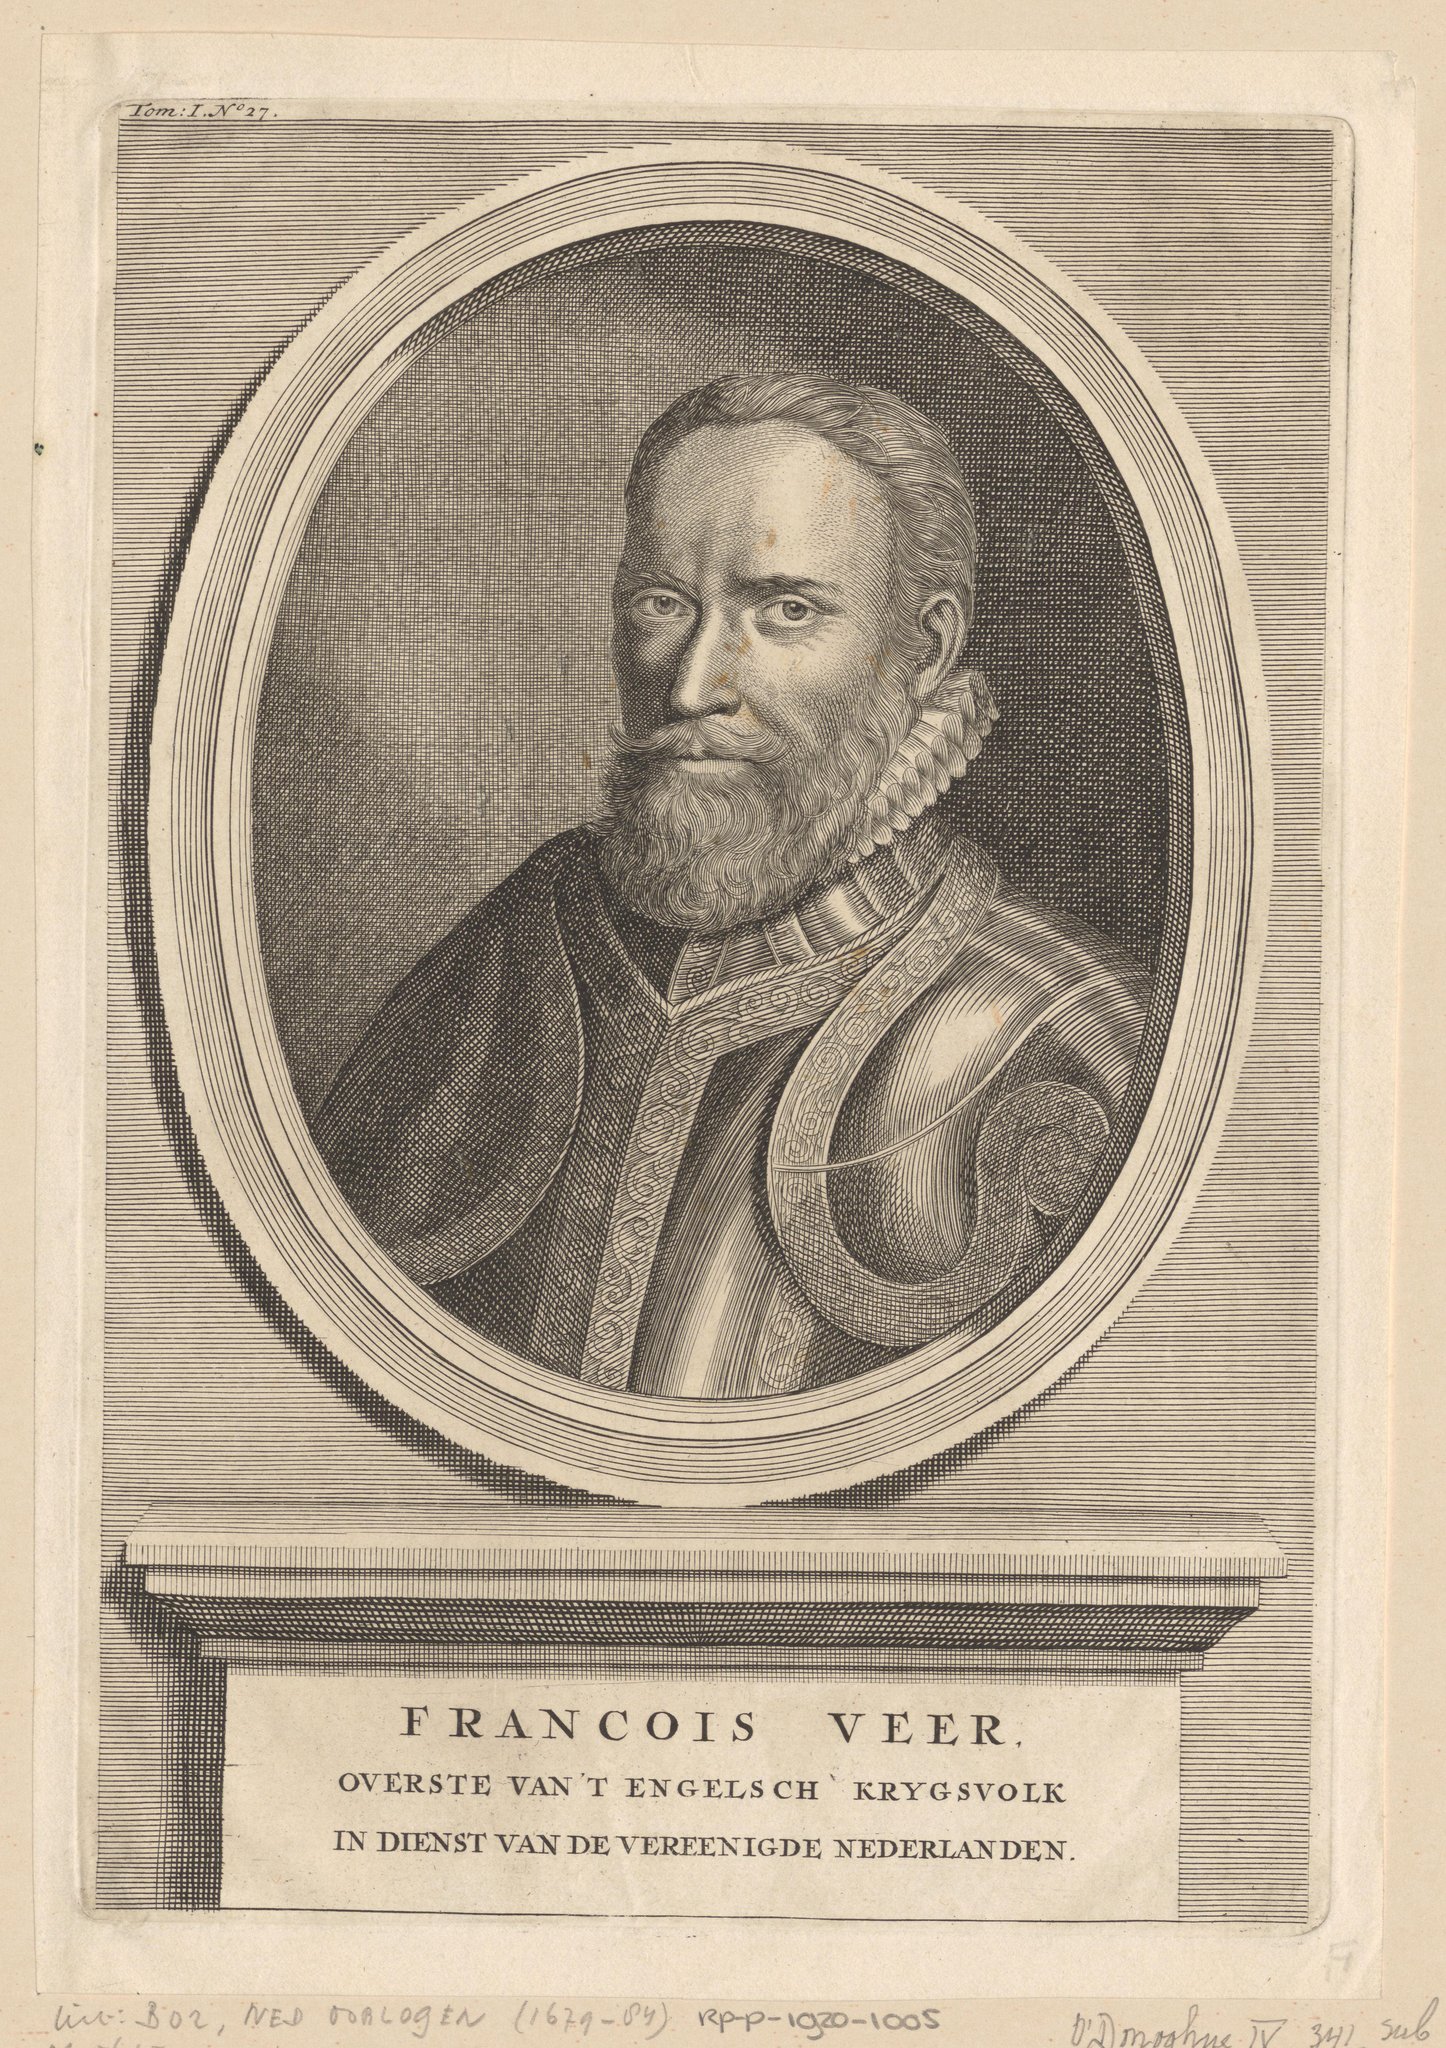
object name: book illustration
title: Portret van Francis Vere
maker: Anonymous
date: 1730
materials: paper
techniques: engraving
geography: northern netherlands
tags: historical persons, officer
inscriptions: collector's mark: Lugt 2228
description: Prent waarschijnlijk uit: Le Clerc, Jean. Geschiedenissen der Vereenigde Nederlanden (...). Amsterdam: Zacharias Chatelain, 1730. Eerdere staat gebruikt in: Bor, Pieter Christiaensz. Oorsprongk, begin, en vervolgh der Nederlandsche oorlogen, beroerten (...). Amsterdam: weduwe Joannes van Someren et al., 1684, dl. 4.